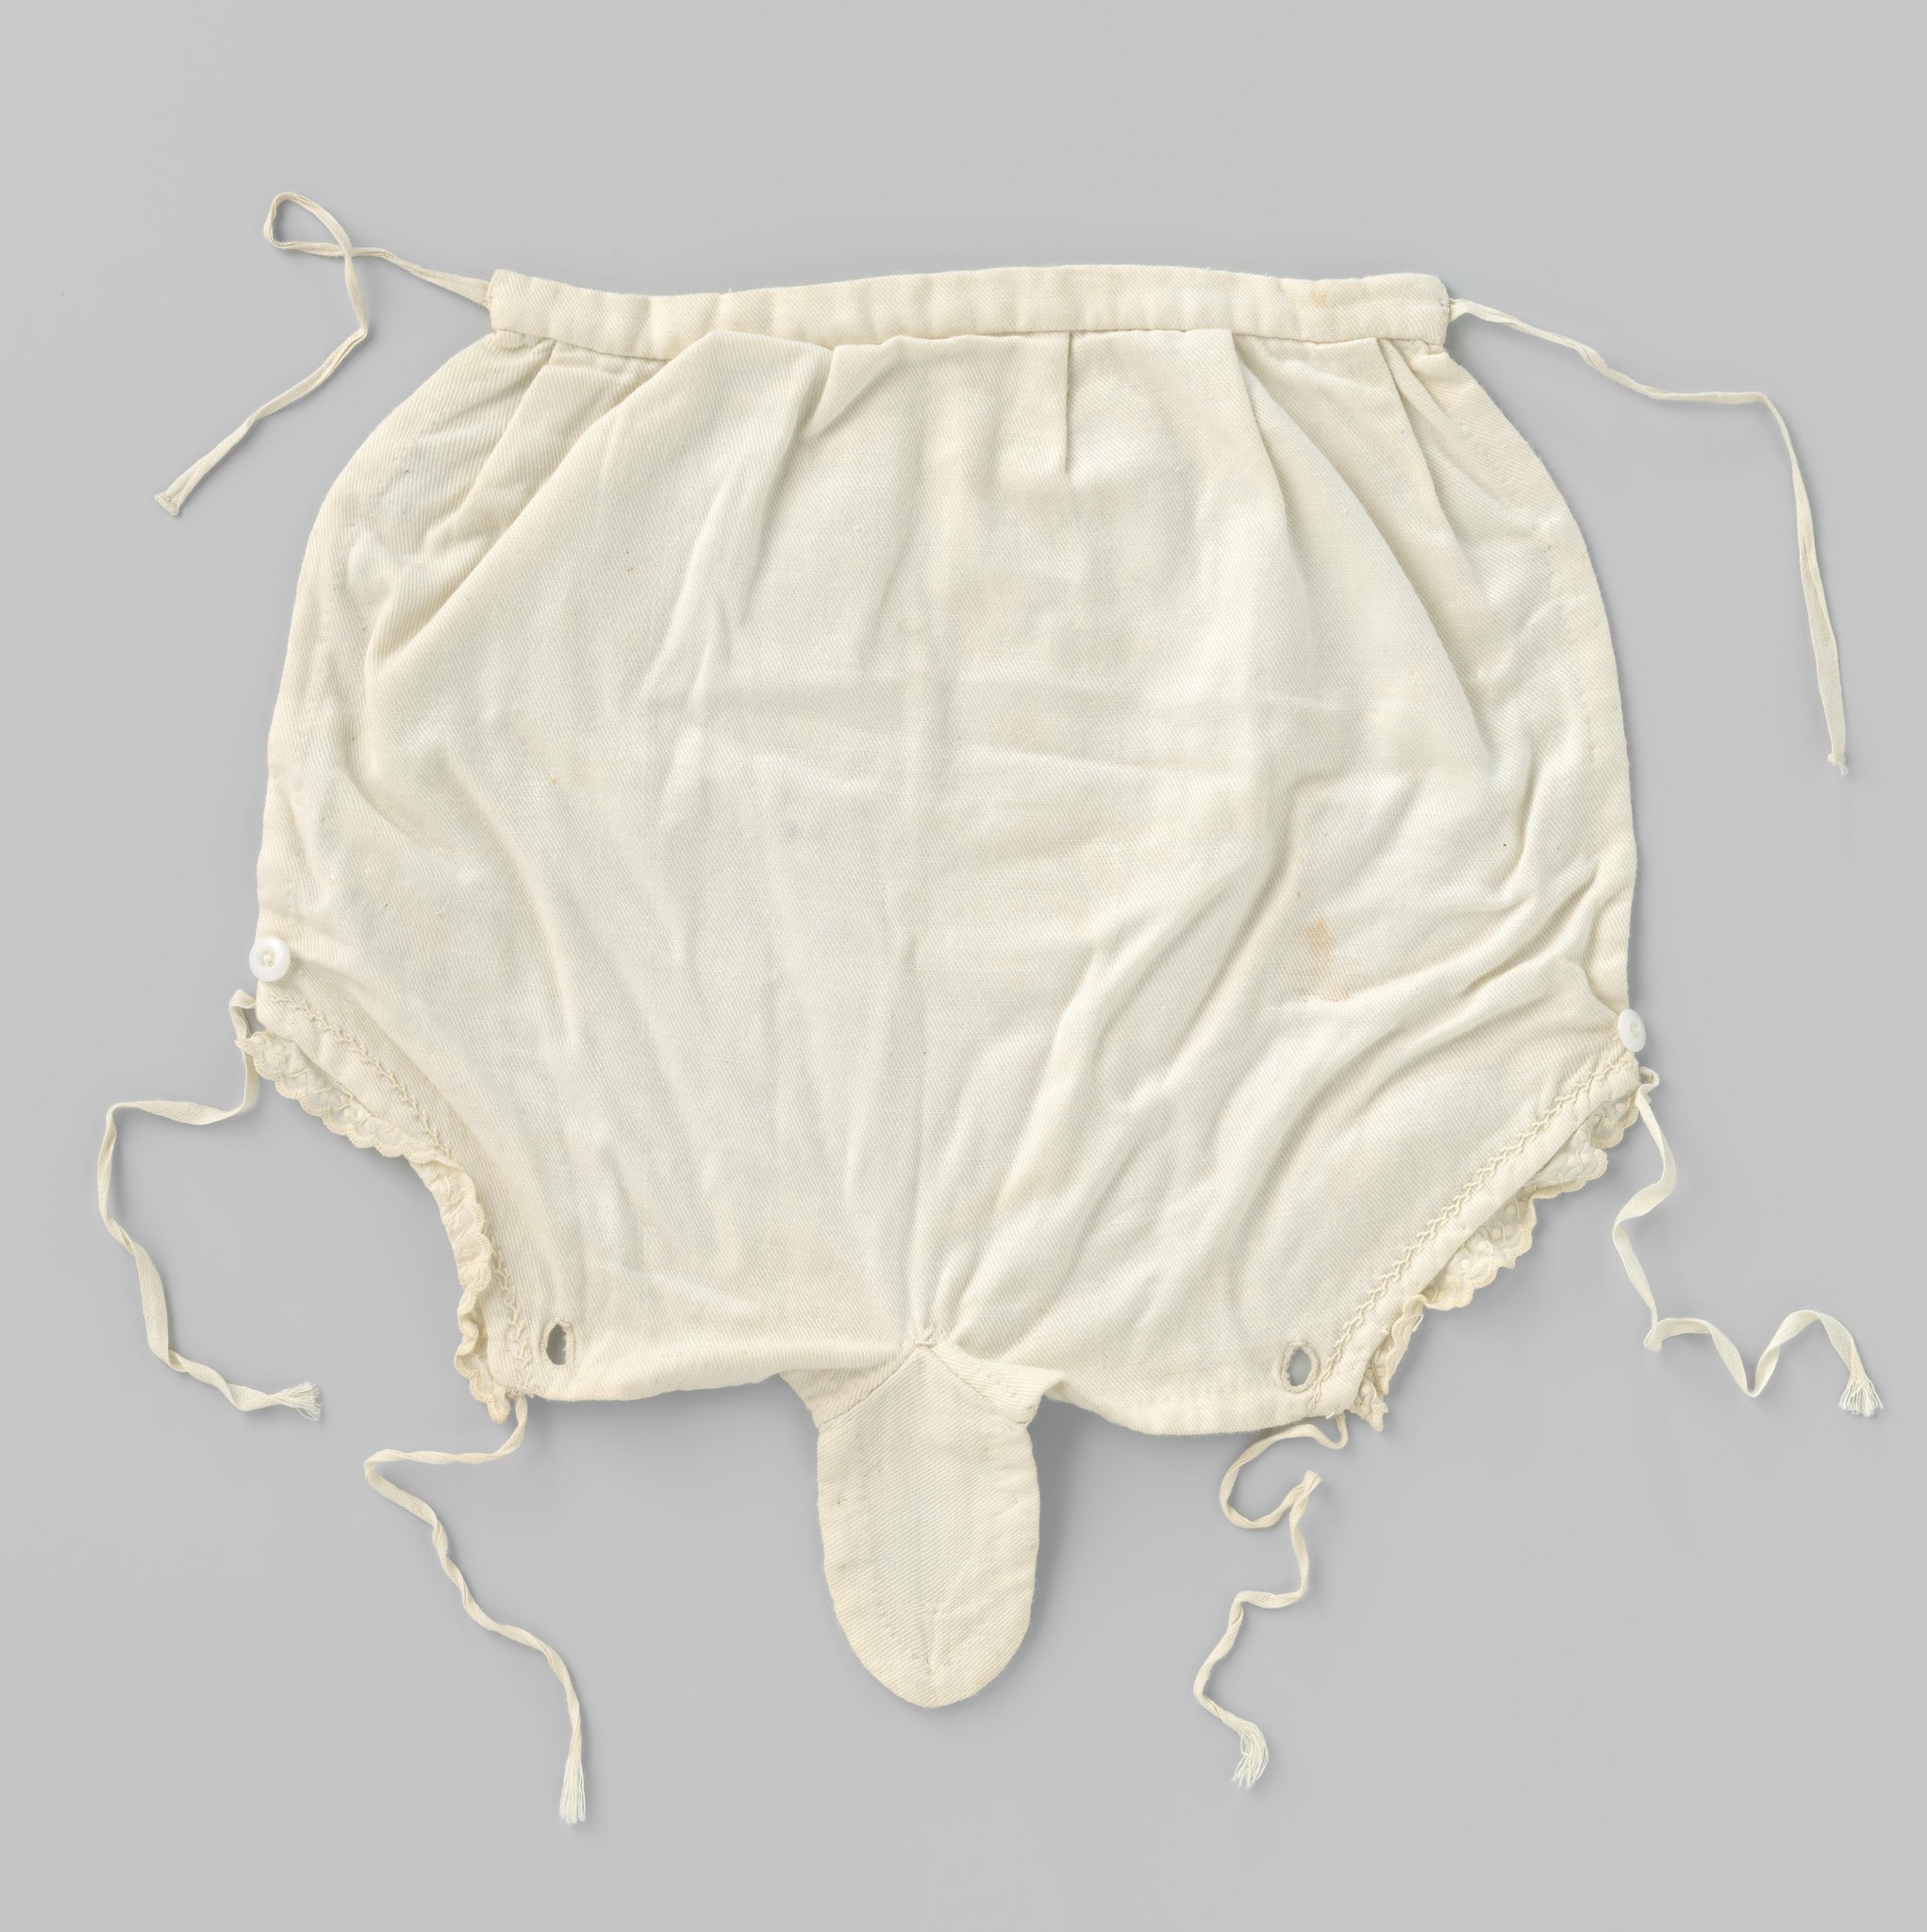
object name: diaper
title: Luier van wit katoen voor pop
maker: Anonymous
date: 1850-1920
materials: cotton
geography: netherlands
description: Aan de luier zes linten en twee witte ronde knopen. Aan de benen is de luier afgezet met geschulpte stroken kant.